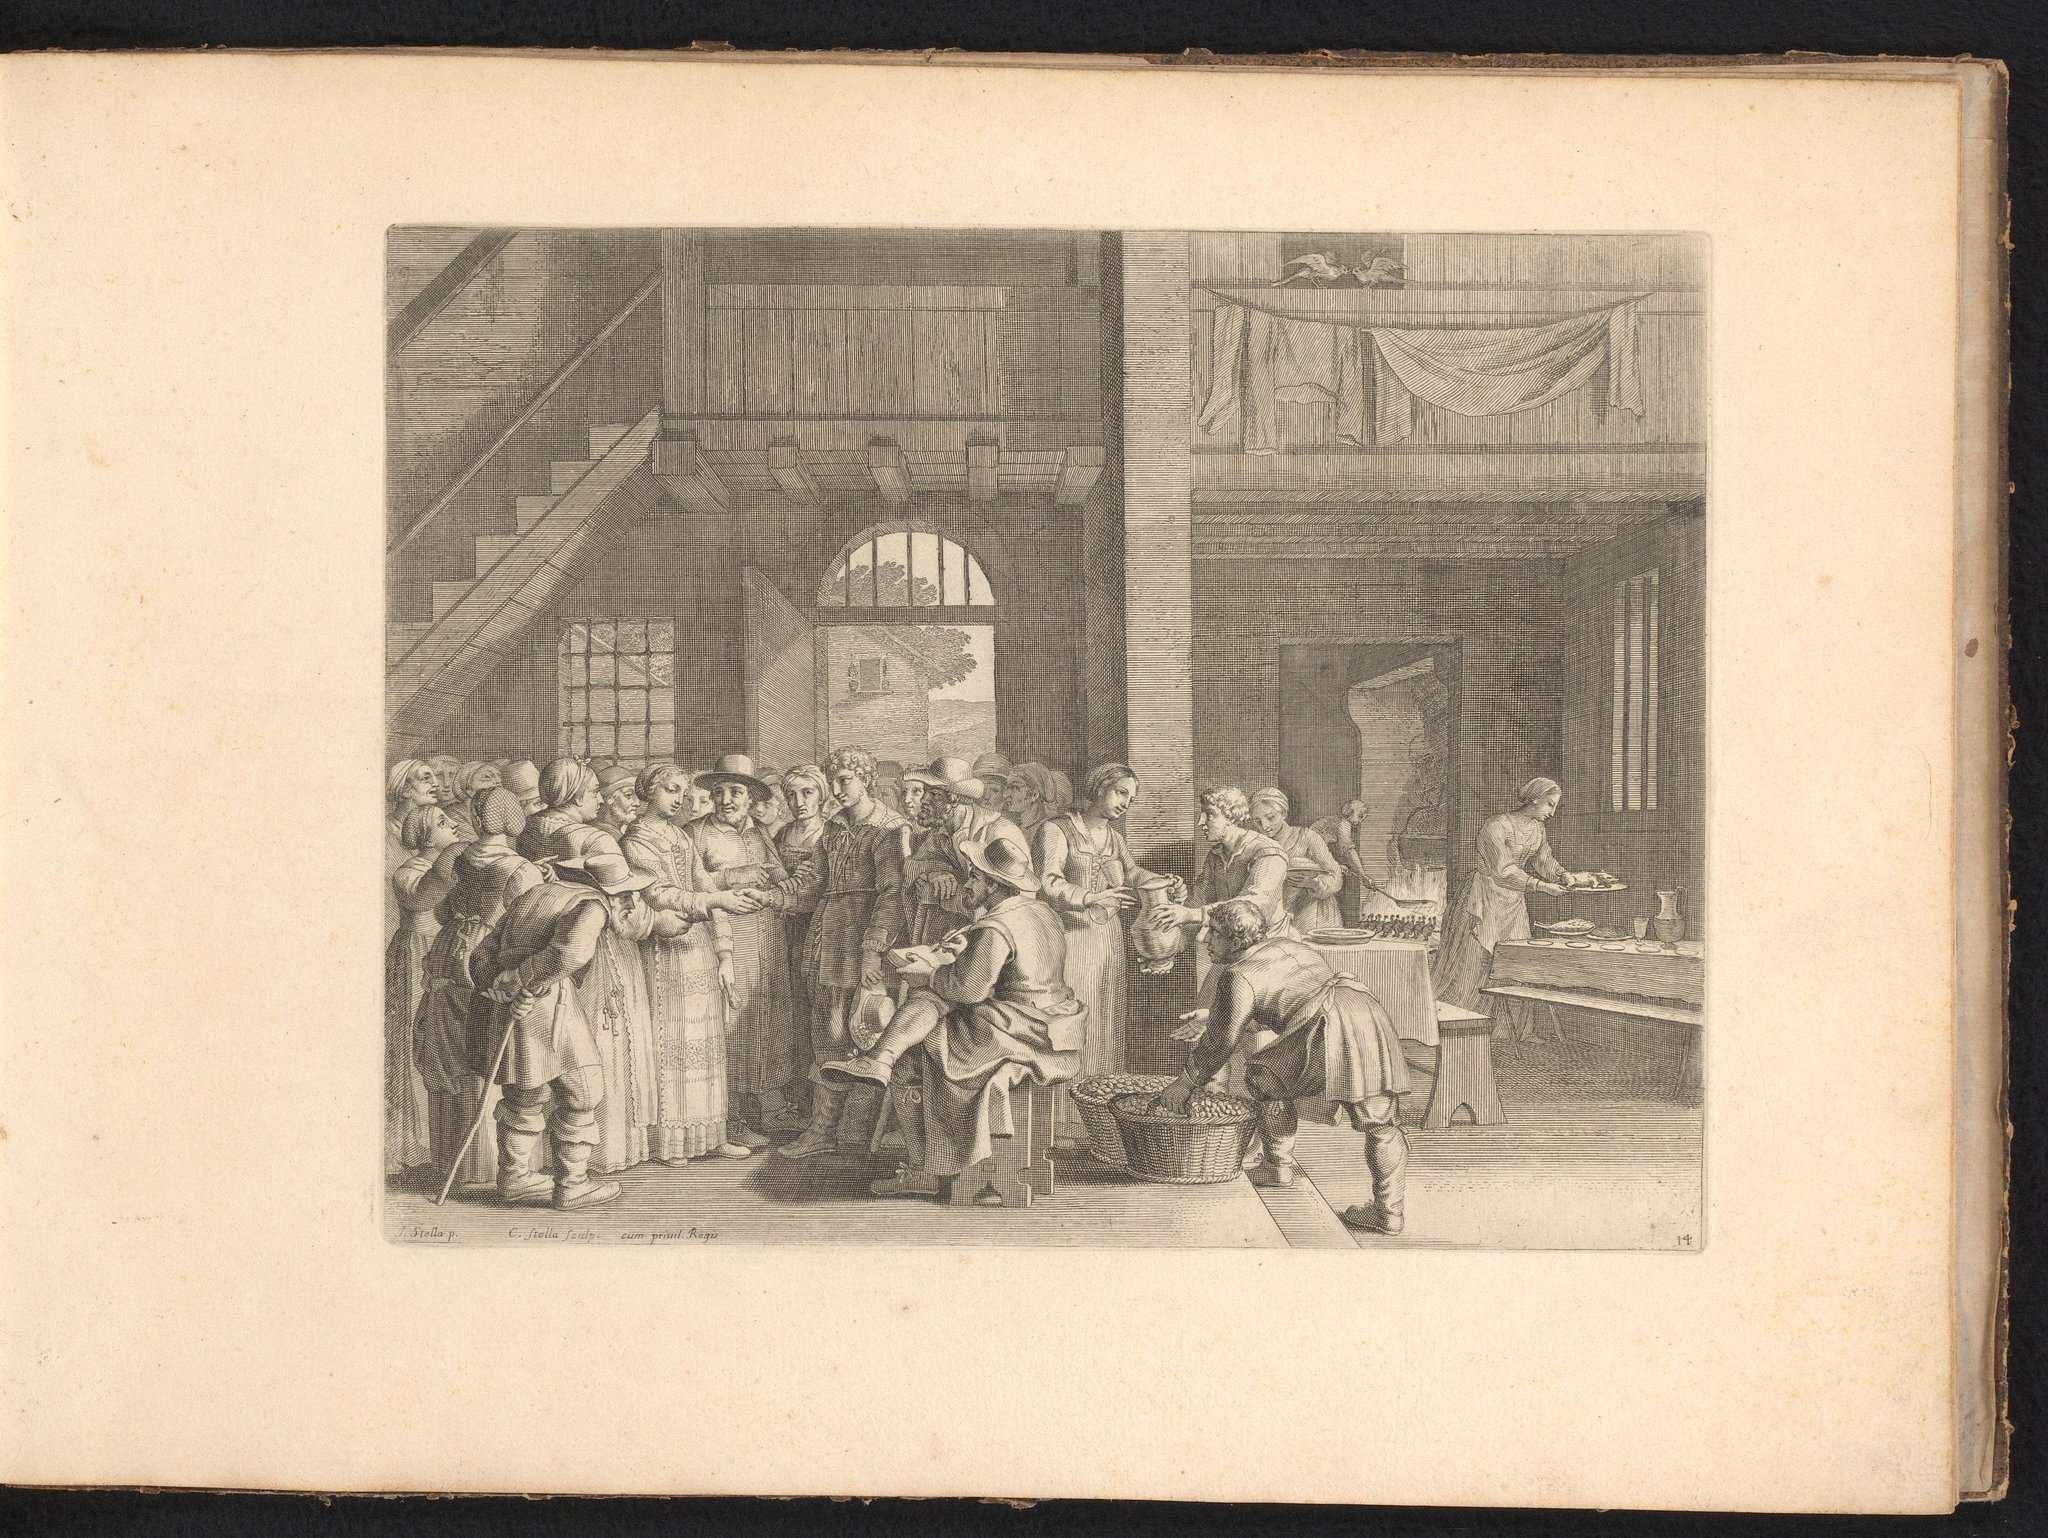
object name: print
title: Pastorale landschappen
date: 1667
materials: paper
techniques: engraving, etching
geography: france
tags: wedding feast, wedding meal, betrothal